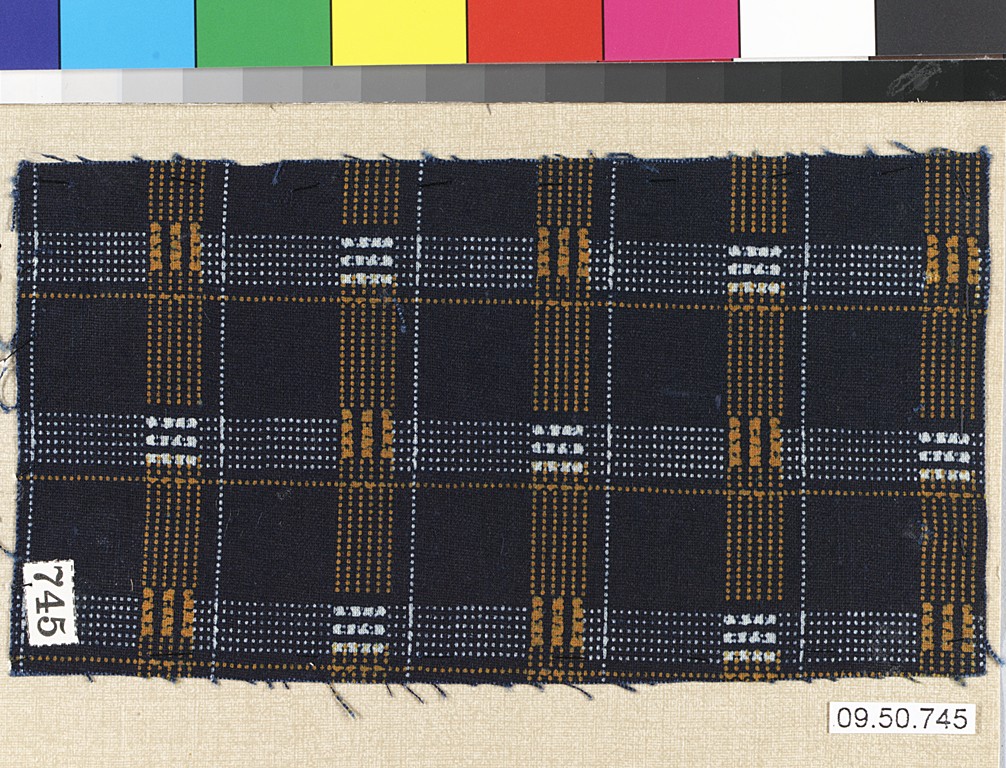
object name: piece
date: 1801-1900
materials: cotton